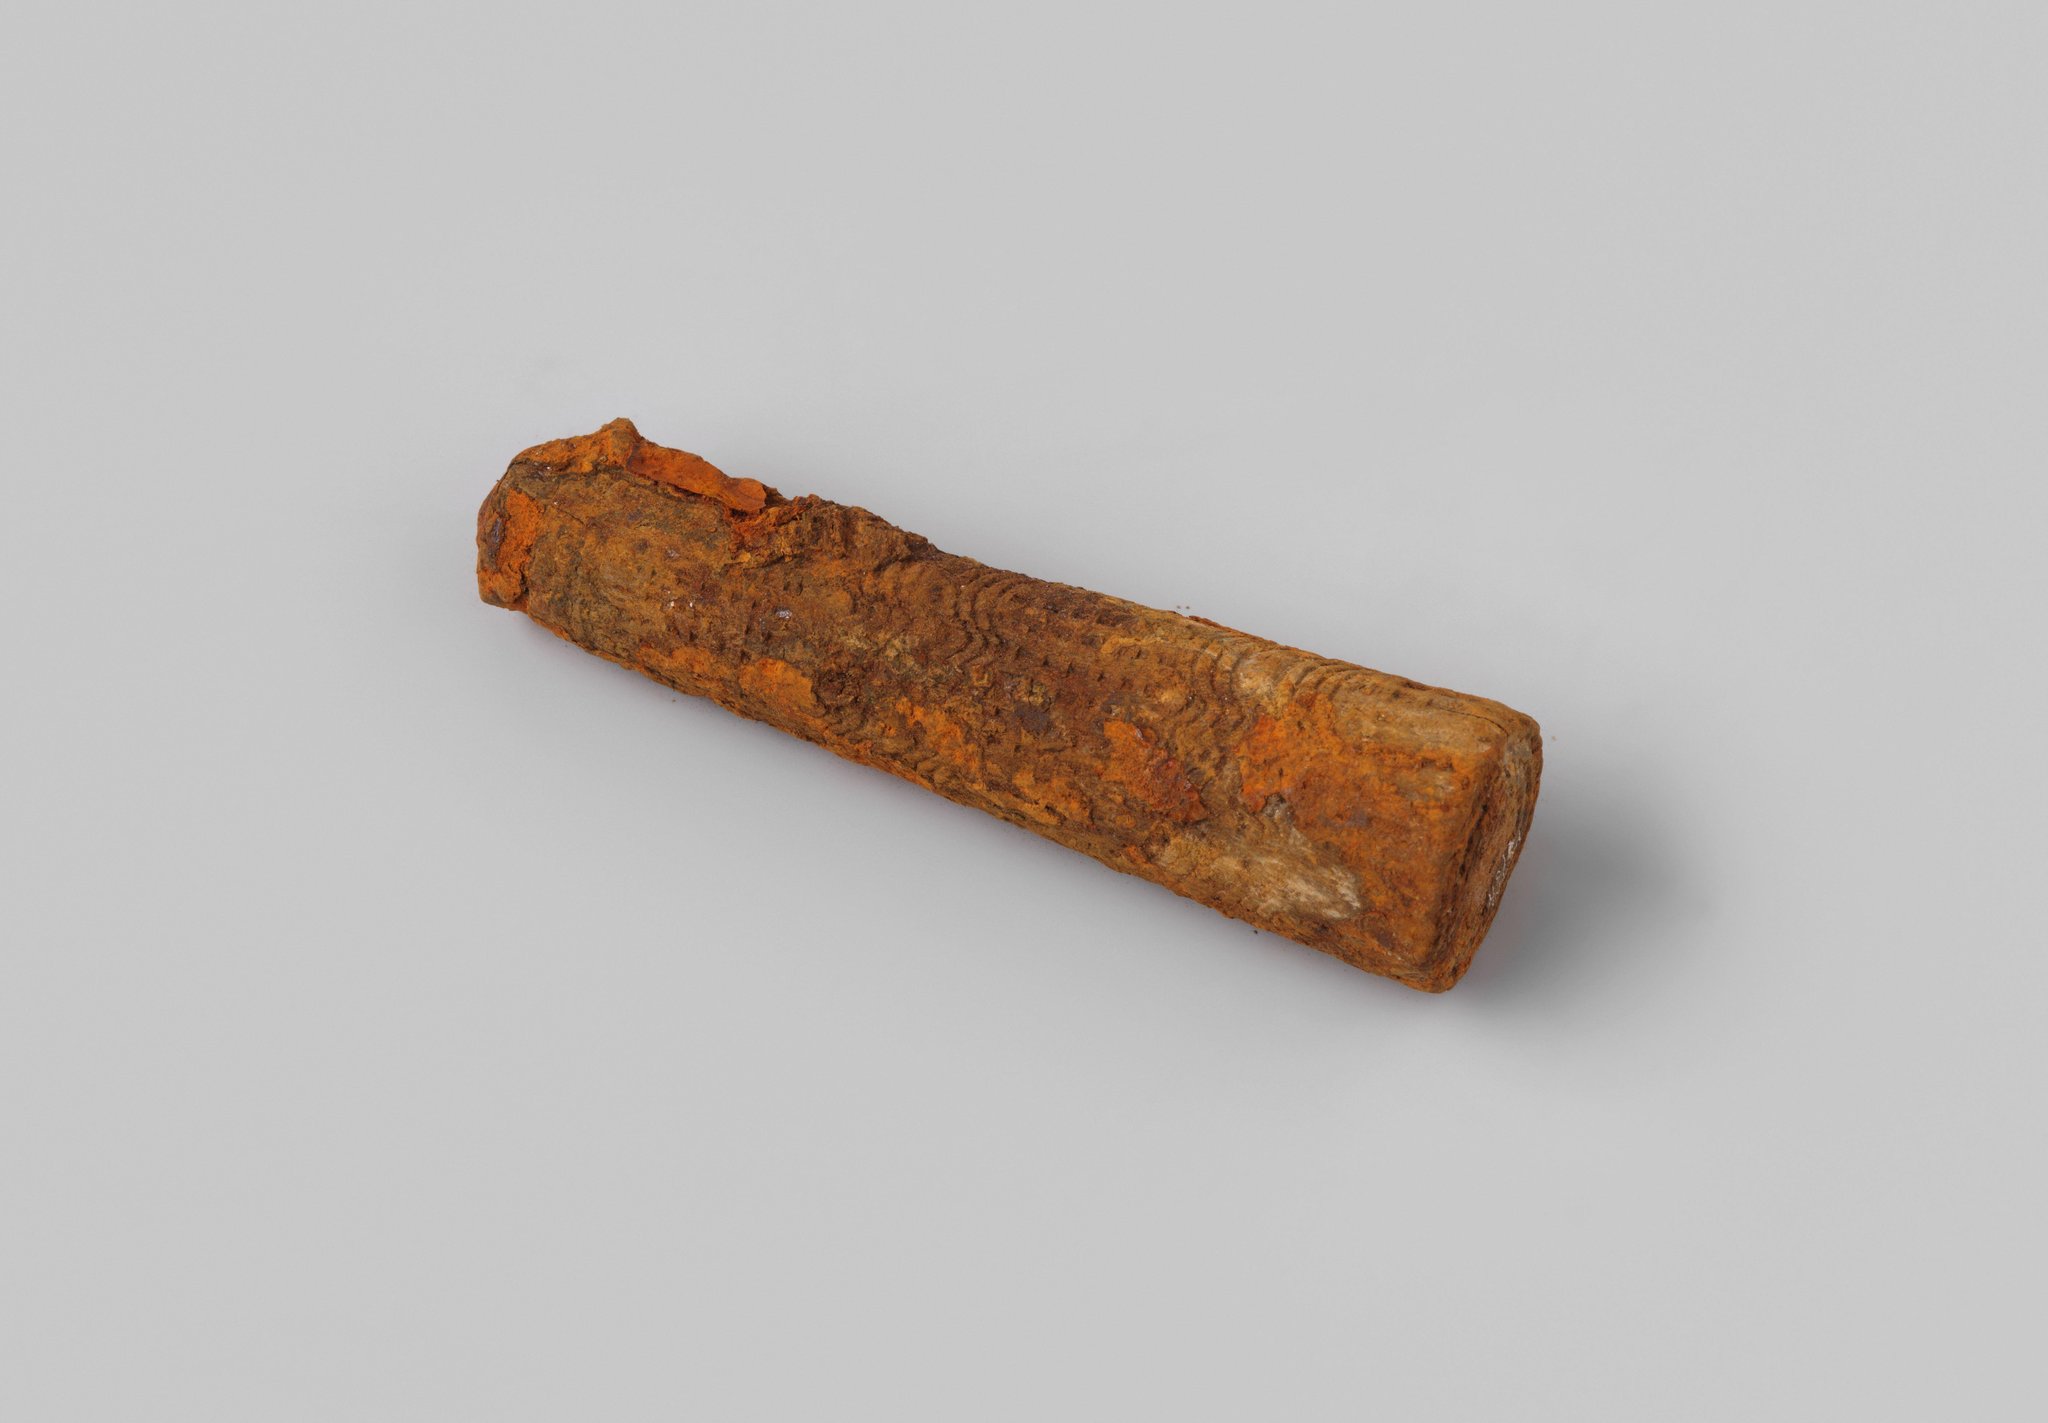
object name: knife handle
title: Messenheft uit het wrak van de Oost-Indiëvaarder Hollandia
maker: Anonymous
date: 1700-1743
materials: wood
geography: netherlands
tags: verenigde oostindische compagnie, hollandia (schip), annet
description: Knife, handle, cylindrical: tapering; id. NG 1979-403H, ferrules id. NG 1980-27H426.